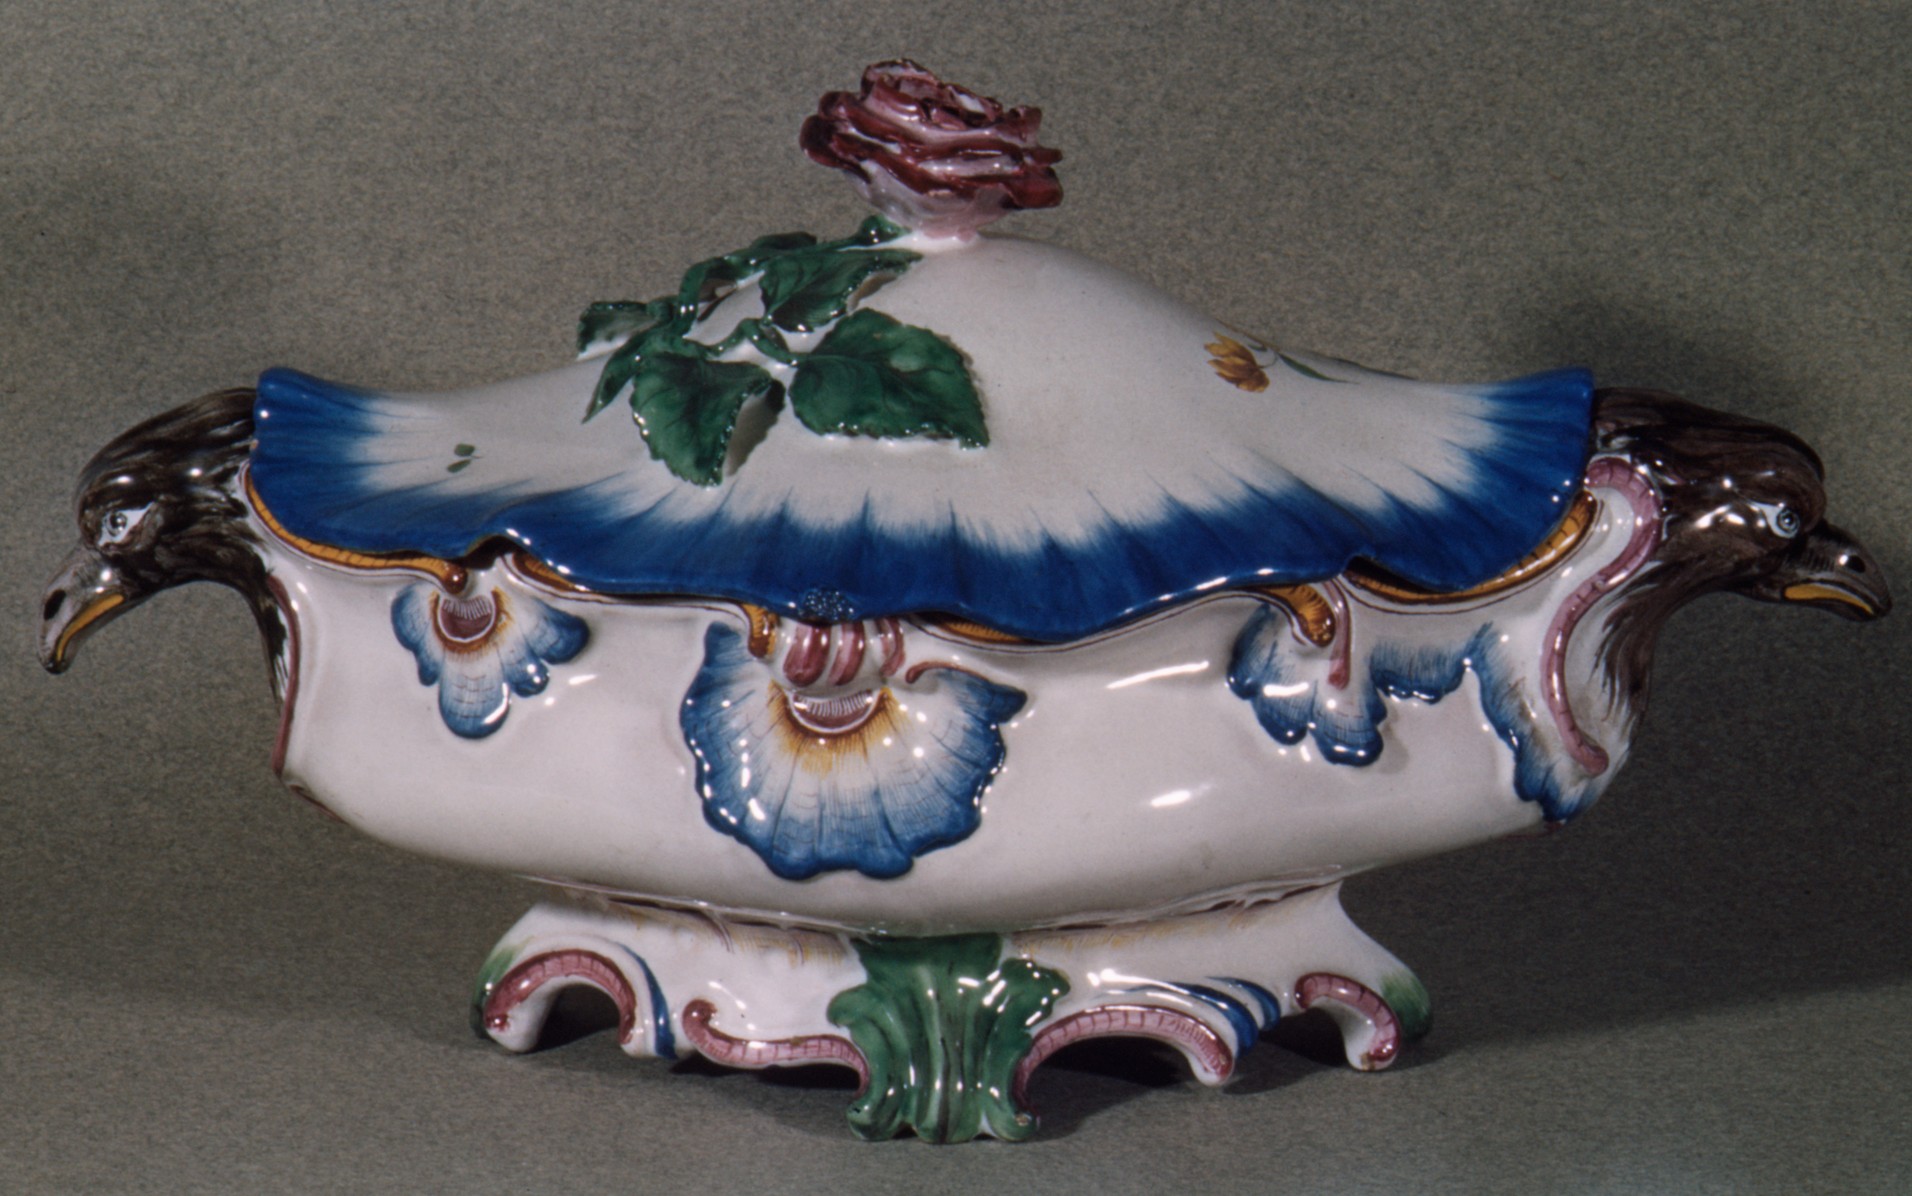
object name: tureen with cover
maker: paul hannong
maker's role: factory owner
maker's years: 1755-1759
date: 1750-1760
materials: faience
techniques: glazing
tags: eagles,flowers